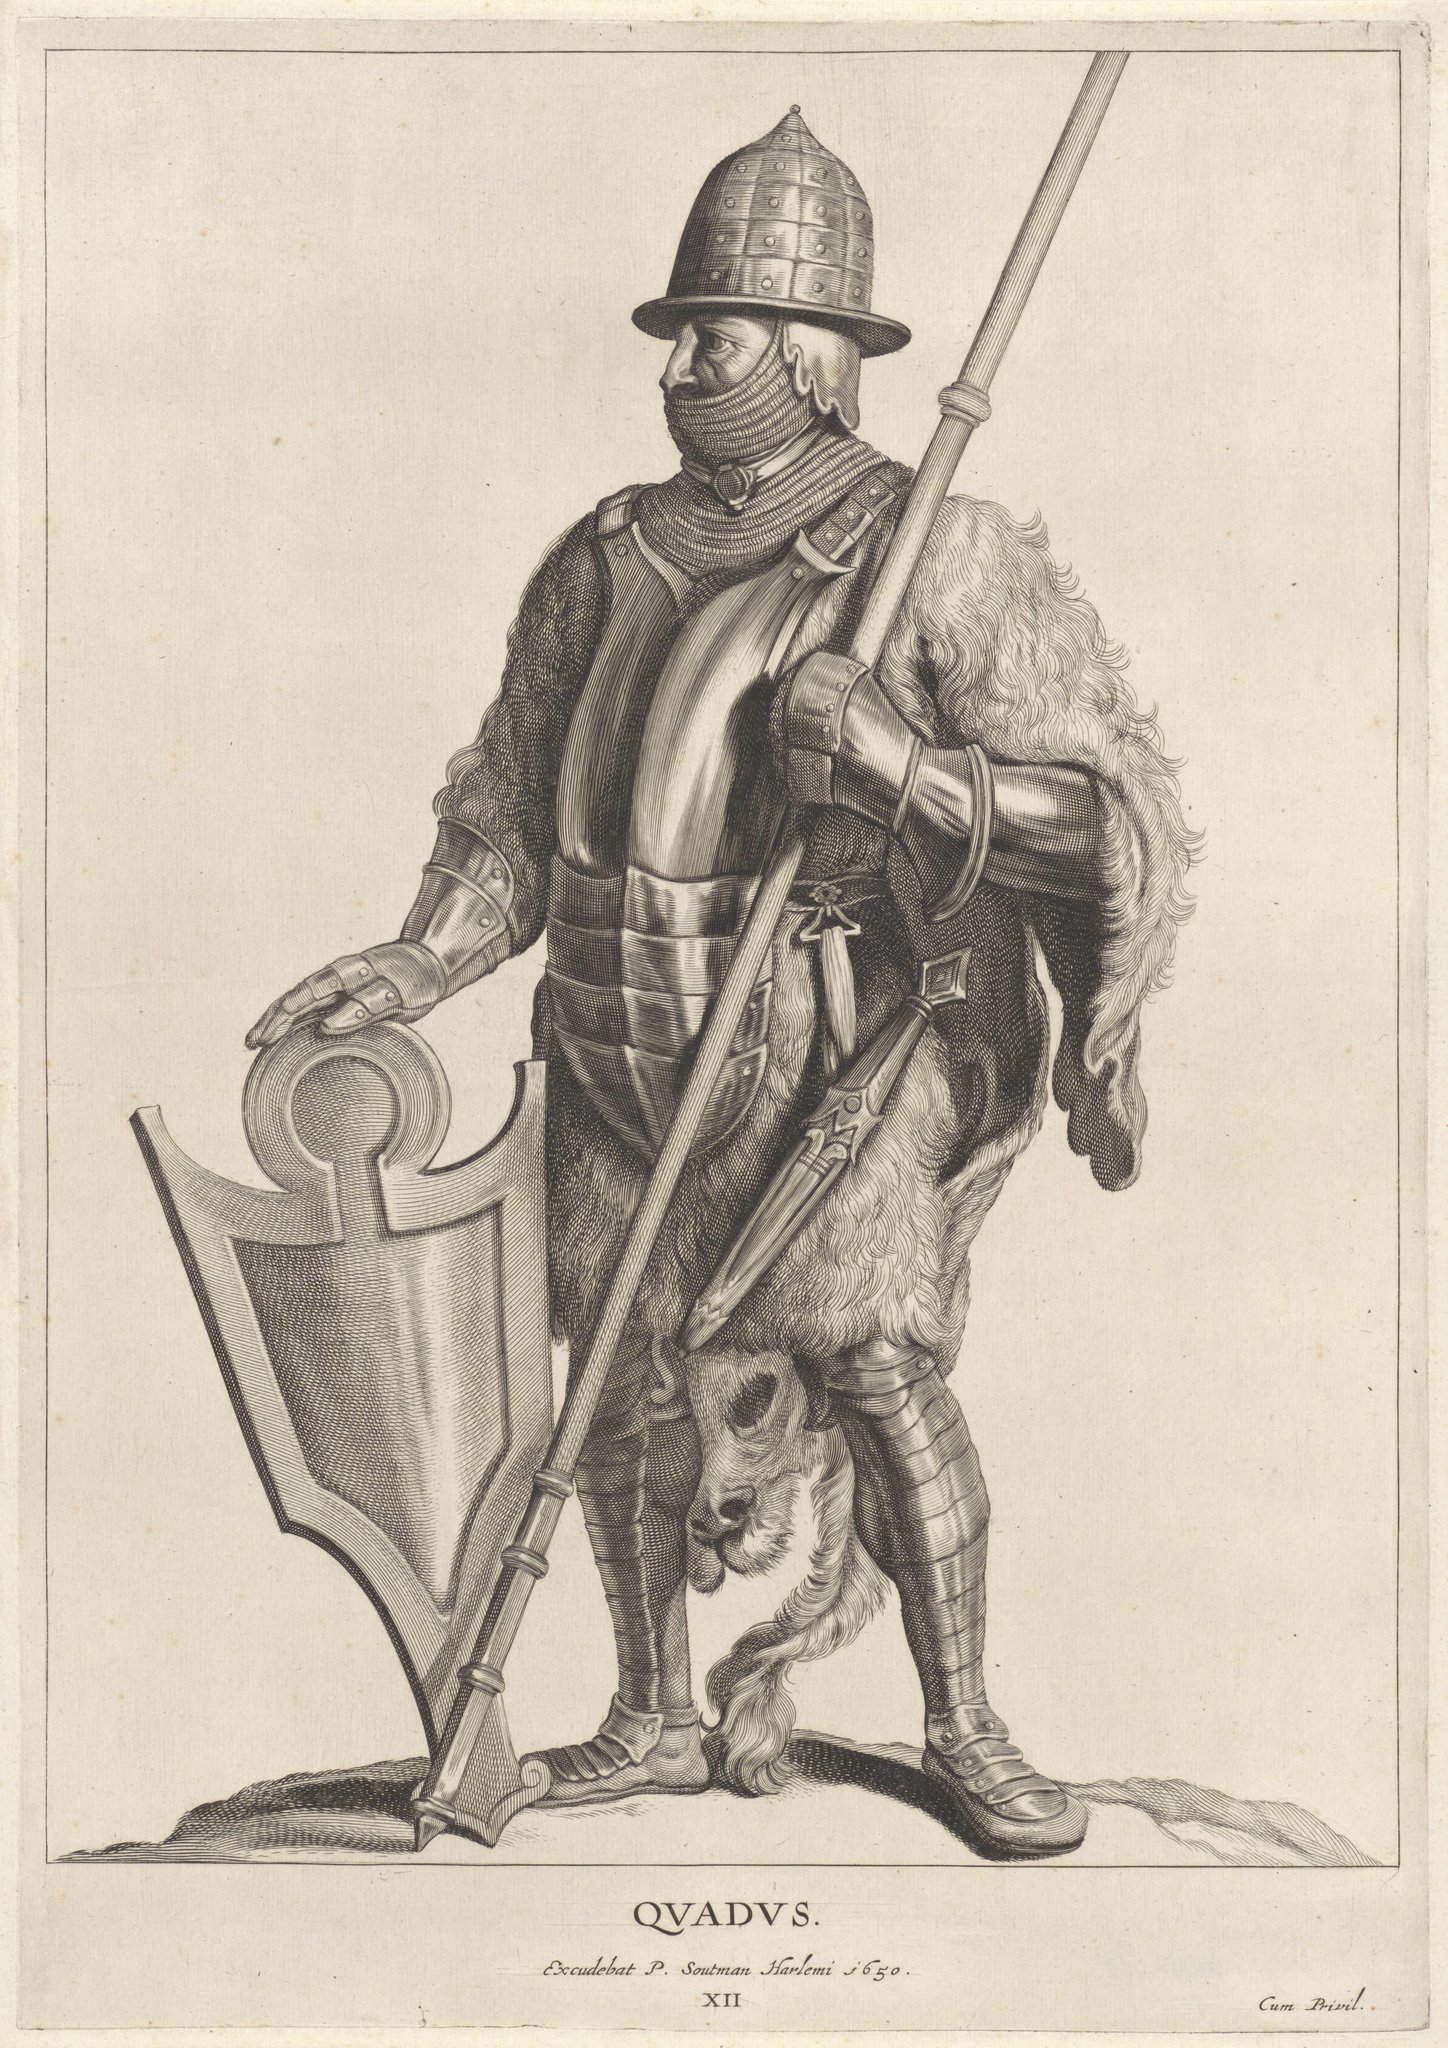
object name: print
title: Quaden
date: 1650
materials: paper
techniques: engraving, etching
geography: haarlem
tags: armour, casting weapons: spear, extinct, 'historical' peoples (with name)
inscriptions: date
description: Krijger van het Germaanse volk der Quaden, staande ten voeten uit in wapenrusting met dierenvel, gewapend met lans en schild.